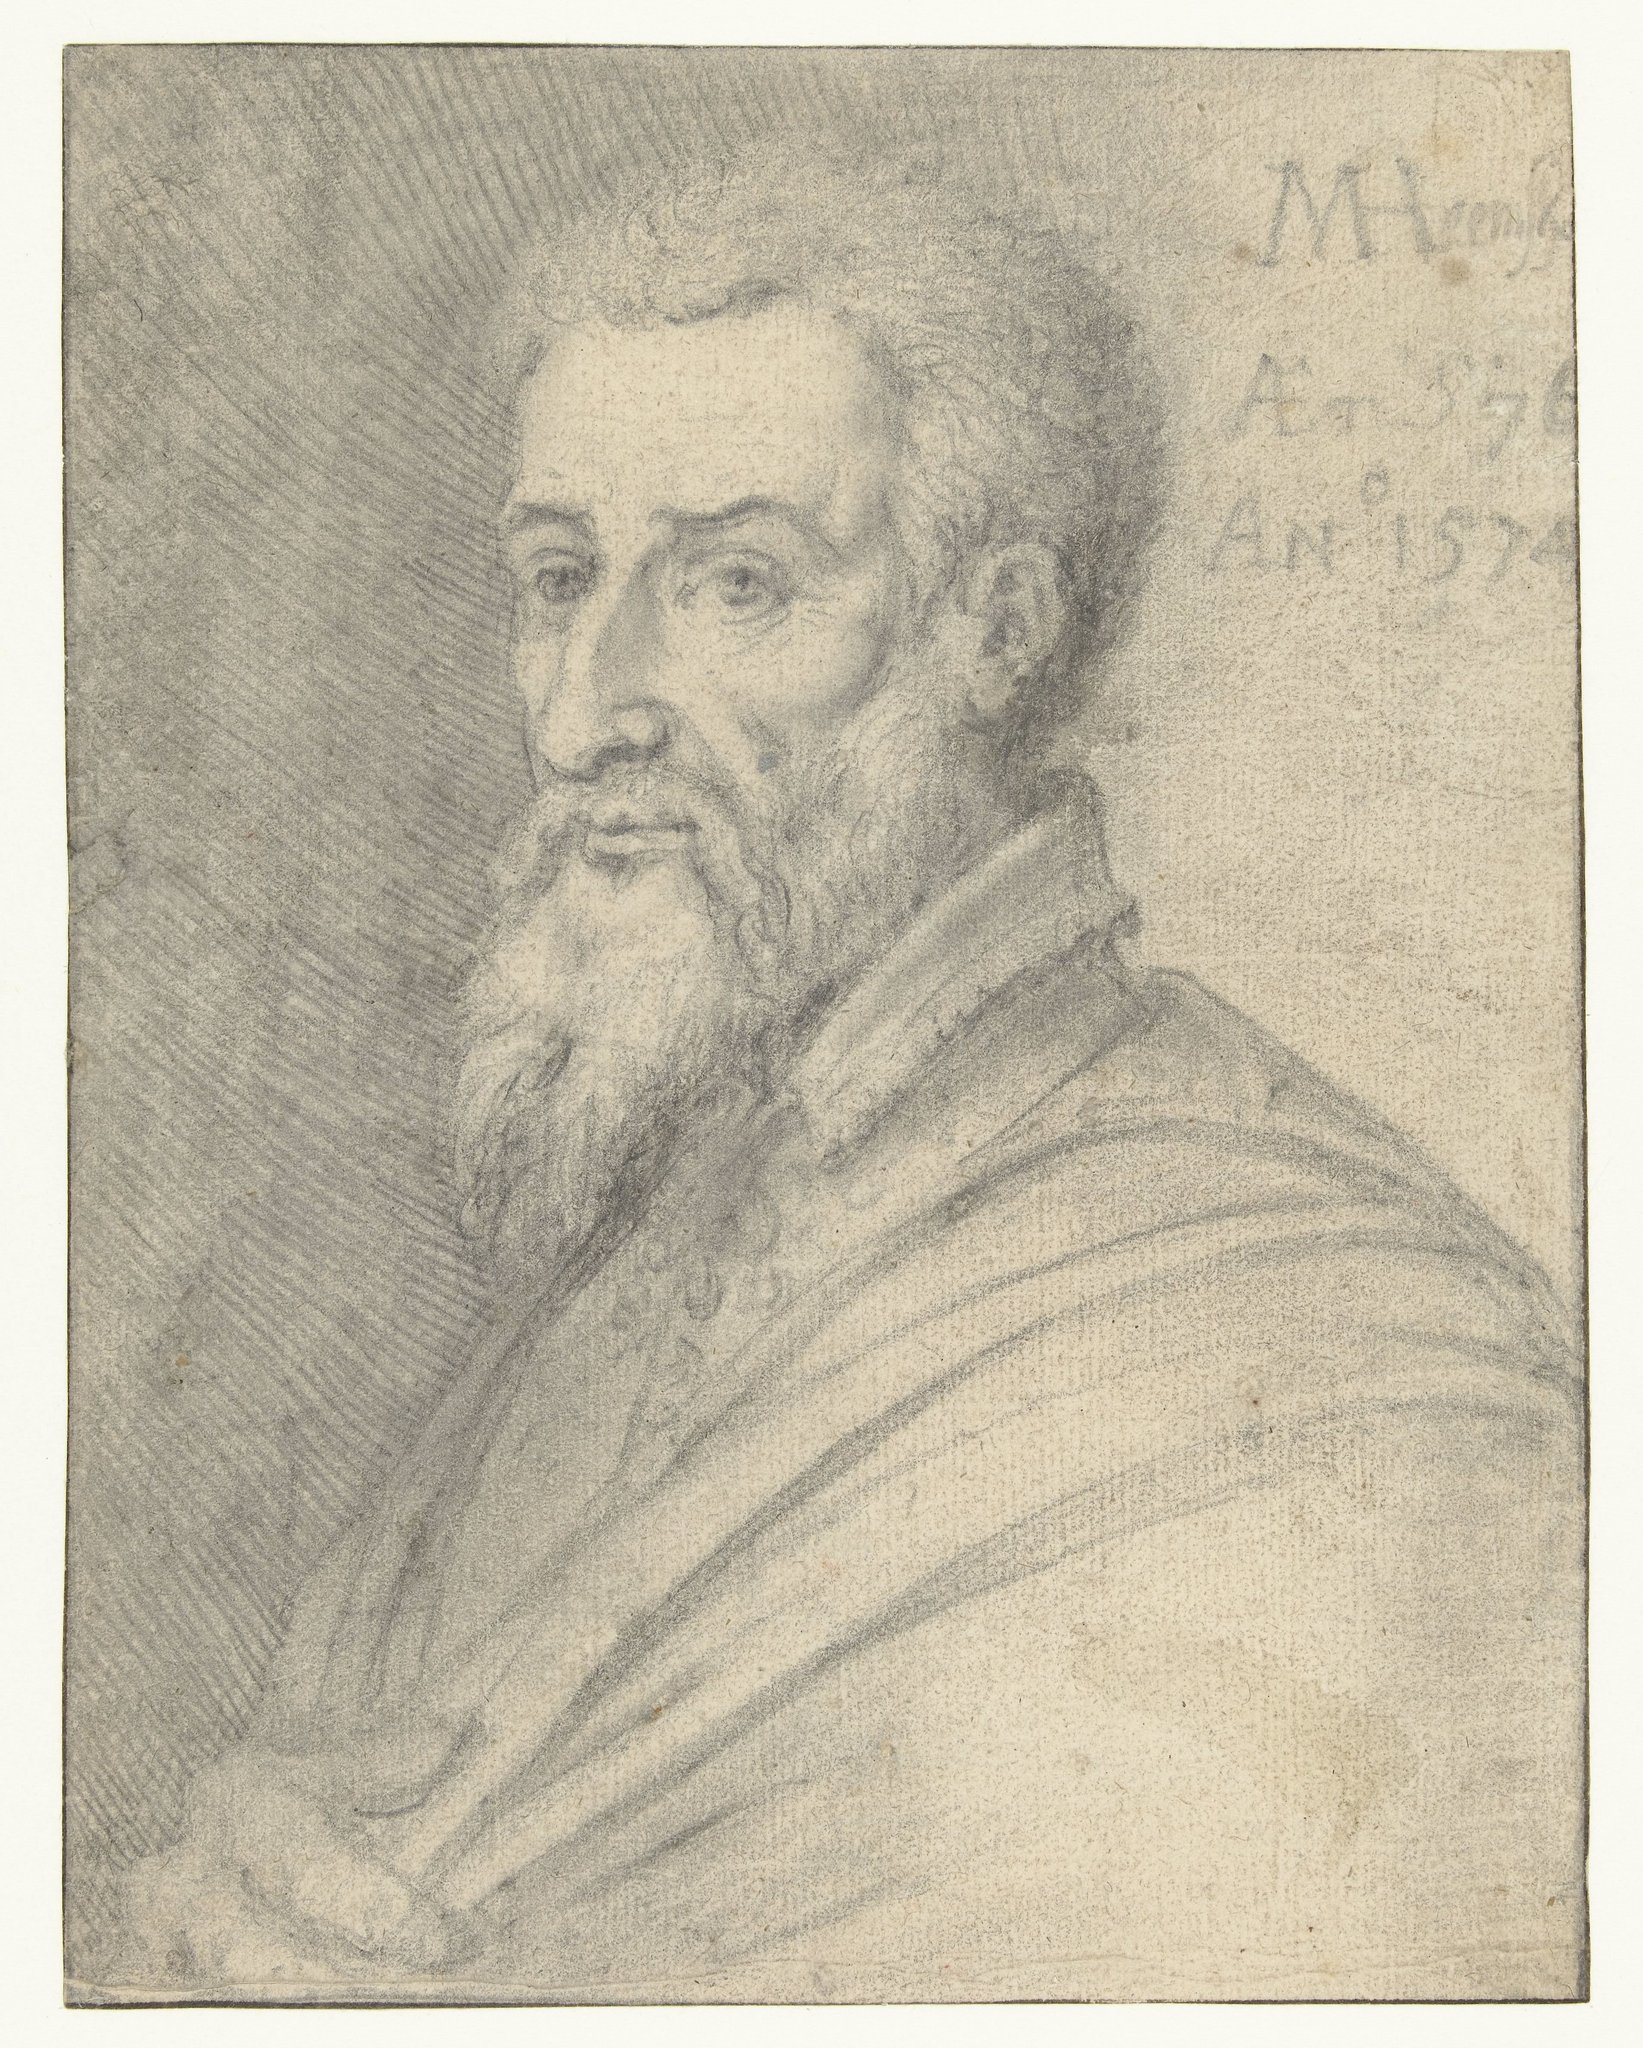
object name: drawing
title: Portret van Maerten van Heemskerck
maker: Anonymous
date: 1574-1579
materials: chalk, paper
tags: haarlem, painter, print maker, draughtsman, maarten van heemskerck, portrait, self-portrait of artist